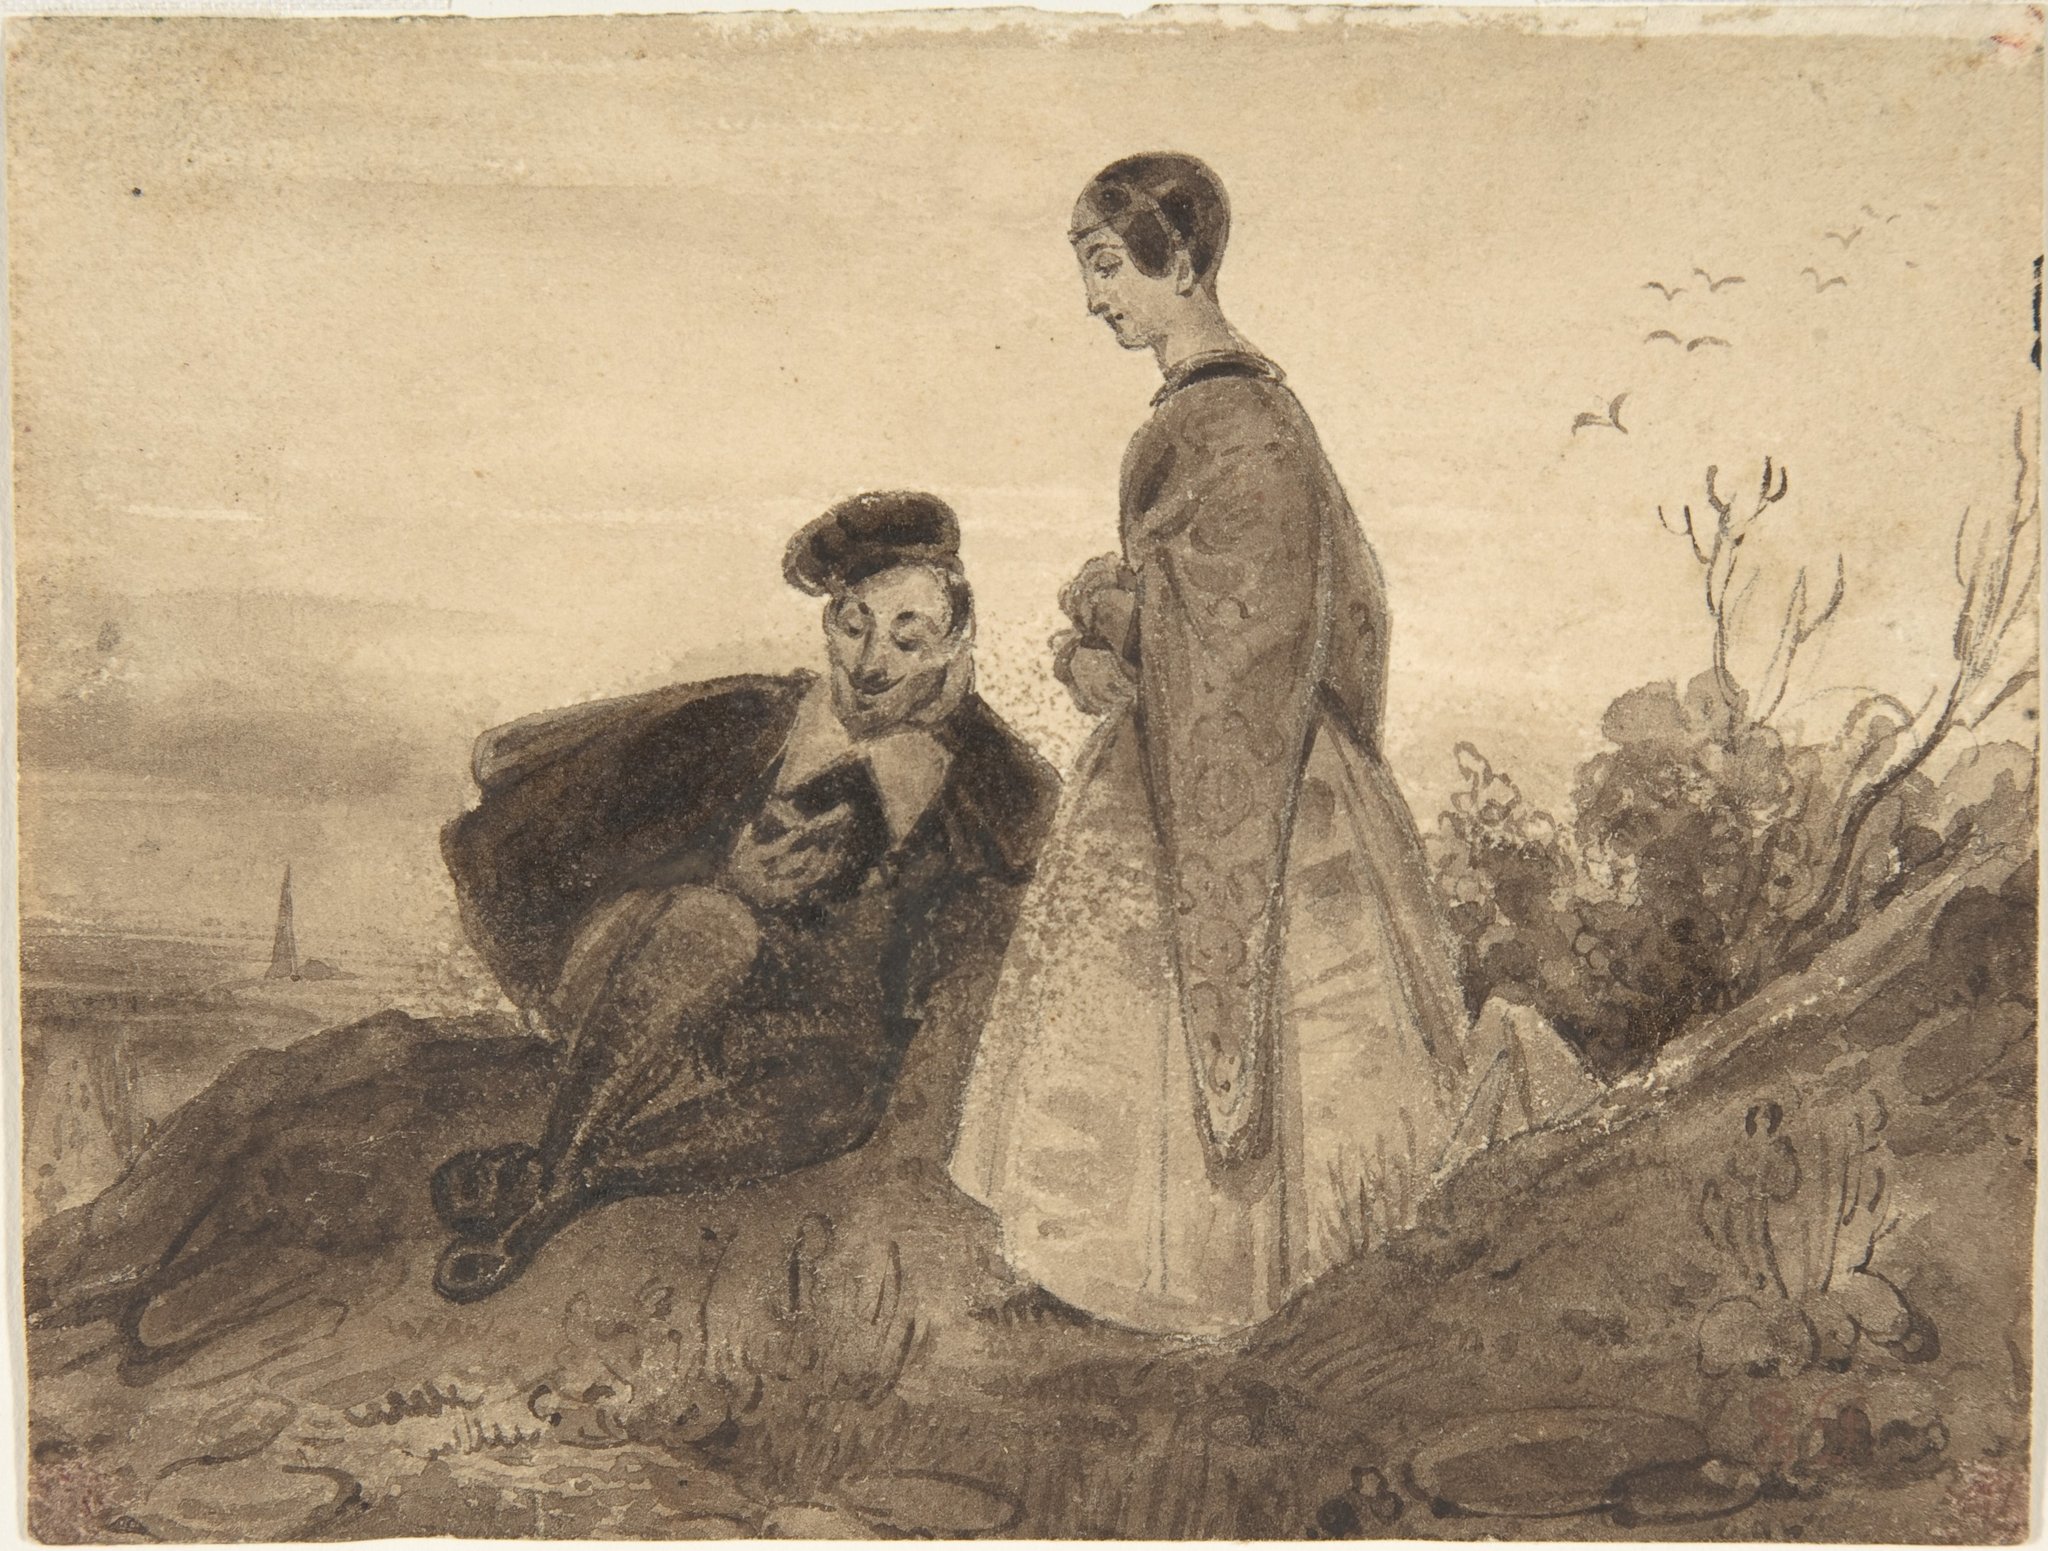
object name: drawing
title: Man and woman in a landscape (Faust and Marguerite)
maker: richard parkes bonington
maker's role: artist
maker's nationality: british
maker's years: 1802-1828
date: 1826-1827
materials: graphite, ink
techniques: brush, pen, wash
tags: men,women,landscapes